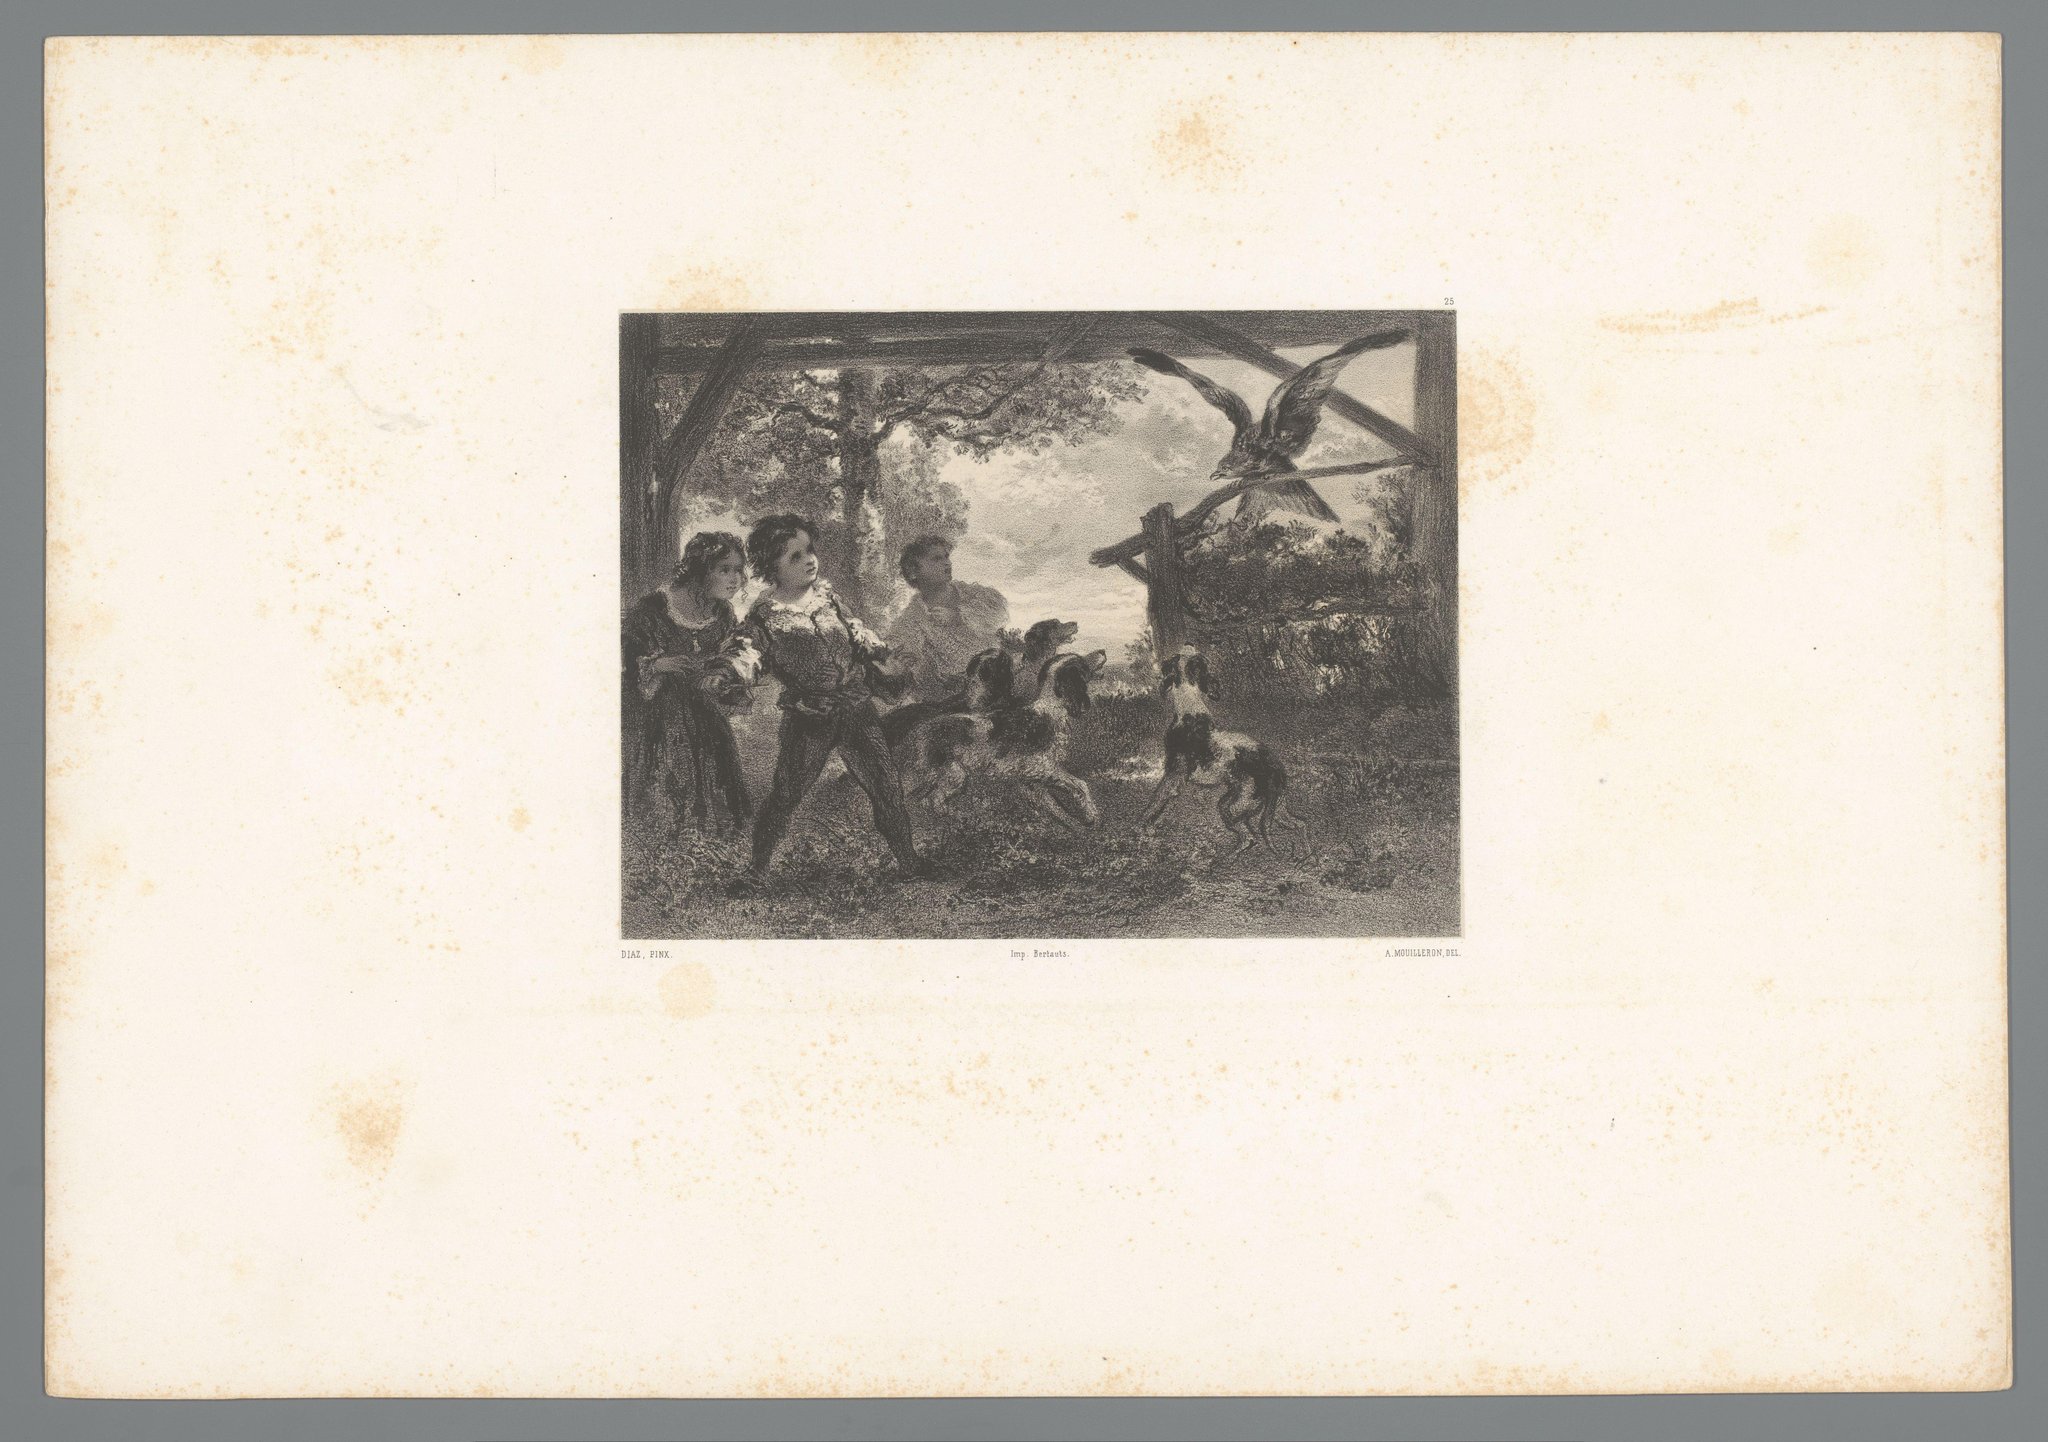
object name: print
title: Enfants à l'aigle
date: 1846-1862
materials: paper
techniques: lithograph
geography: paris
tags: predatory birds: eagle, child (+ two persons), dog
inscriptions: collector's mark: Lugt 964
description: Prent is waarschijnlijk verschenen in de serie 'Les artistes anciens et modernes' (zie Lugt 36a en 4801) of de serie 'Les artistes contemporains' (zie Lugt 36b).